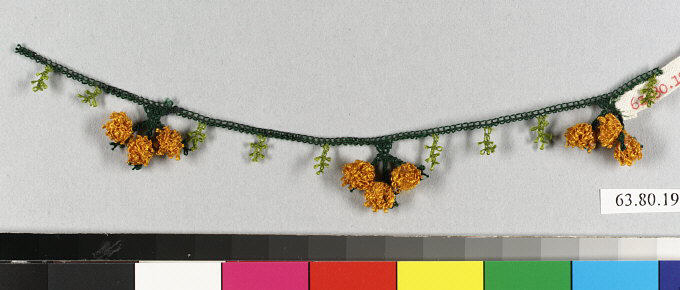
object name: piece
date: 1801-1900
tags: flowers,leaves